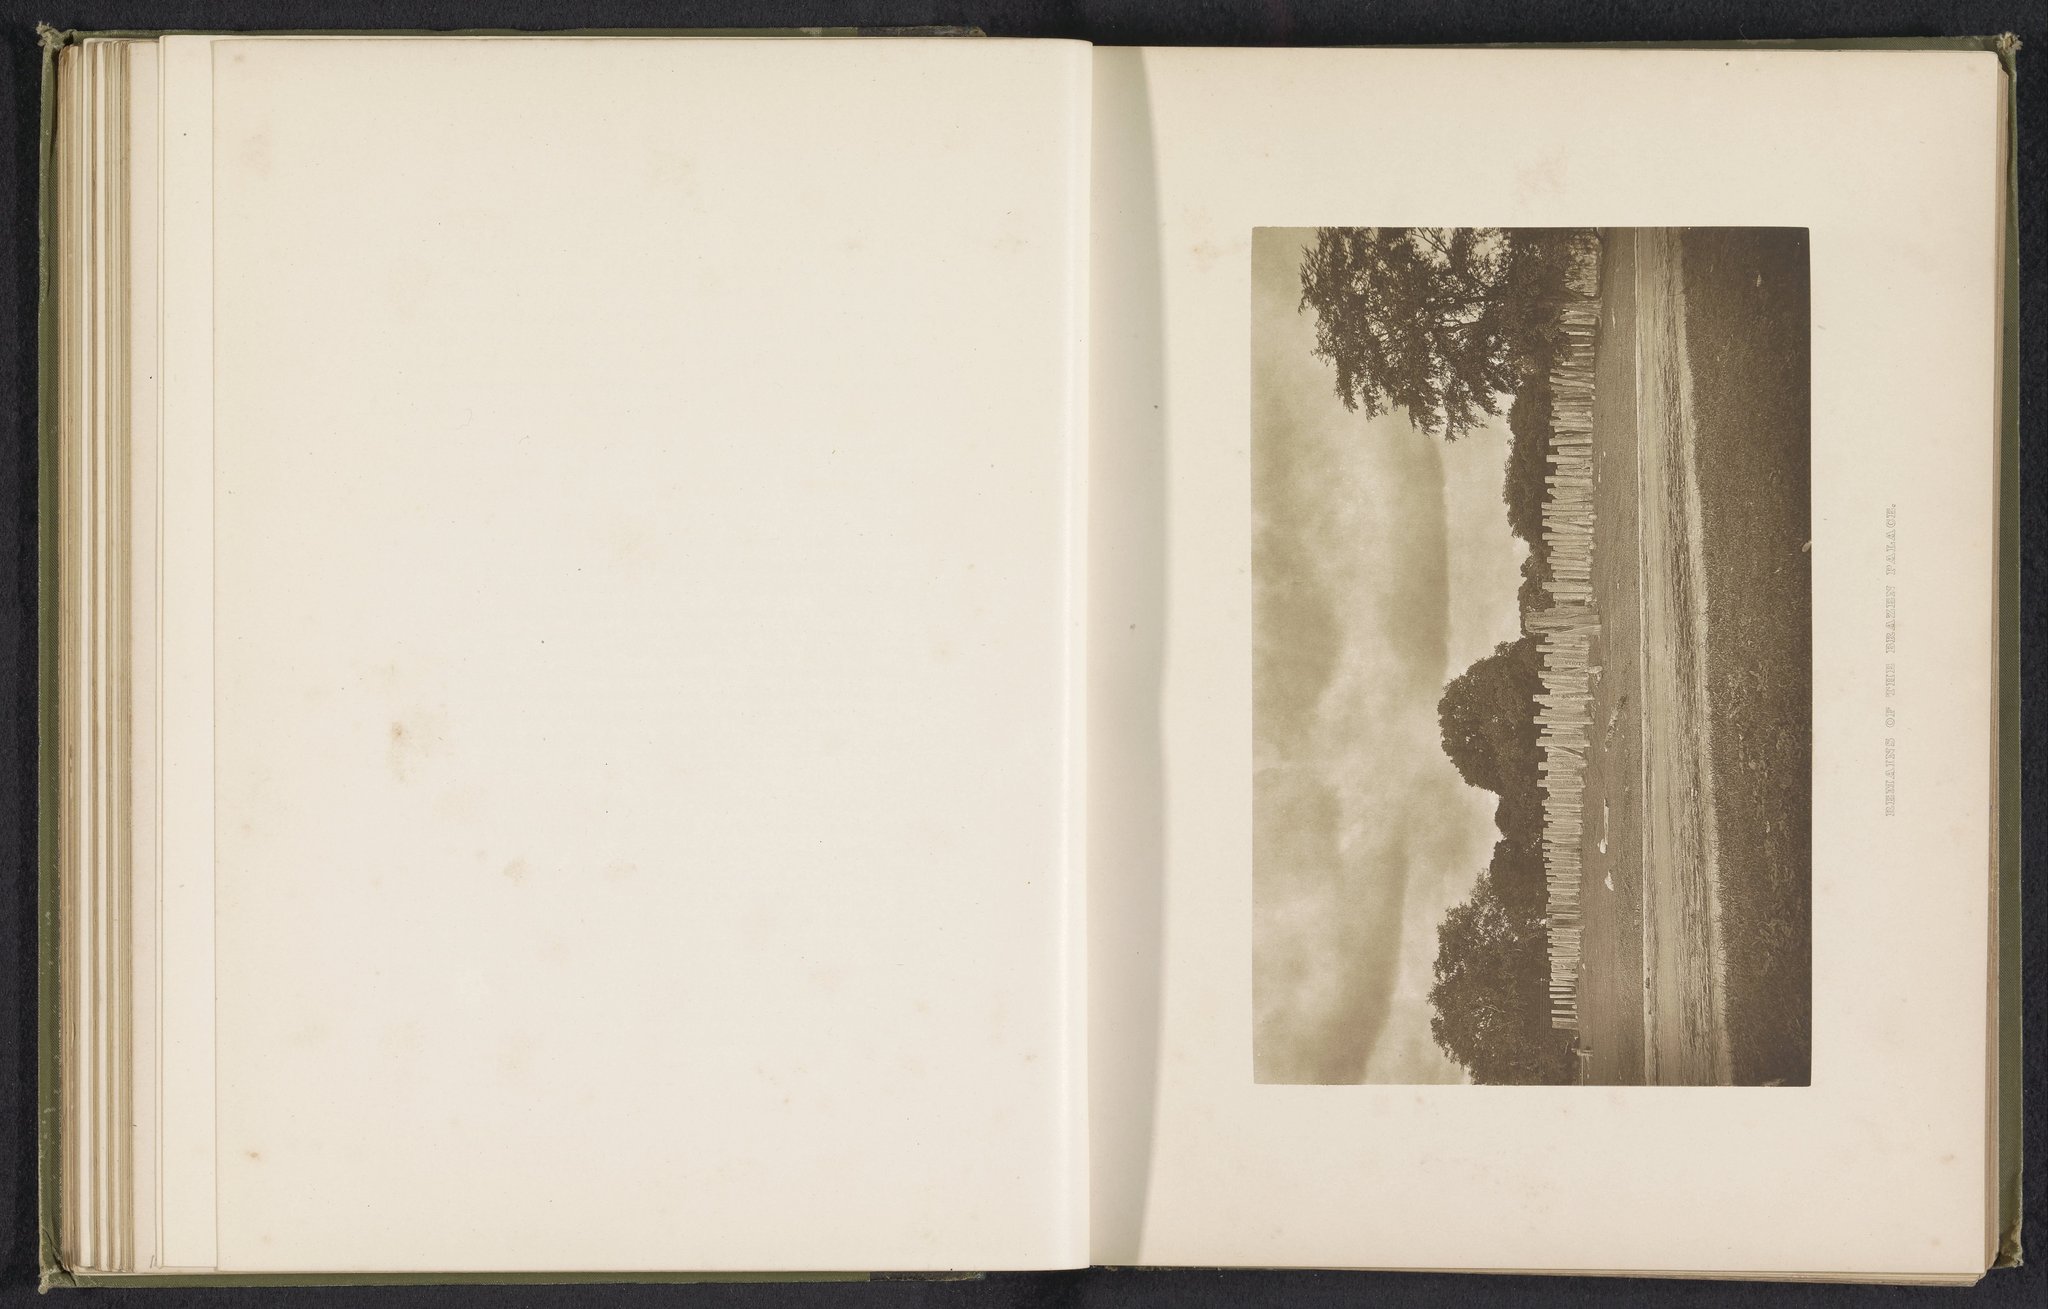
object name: photomechanical print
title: Ruins of the Lovamahapaya building in Anuradhapura, Sri Lanka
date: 1896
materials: paper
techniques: woodburygravure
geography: anuradhapura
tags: ruin of a dwelling, house, castle, etc.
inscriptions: title: ‘REMAINS OF THE BRAZEN PALACE.’